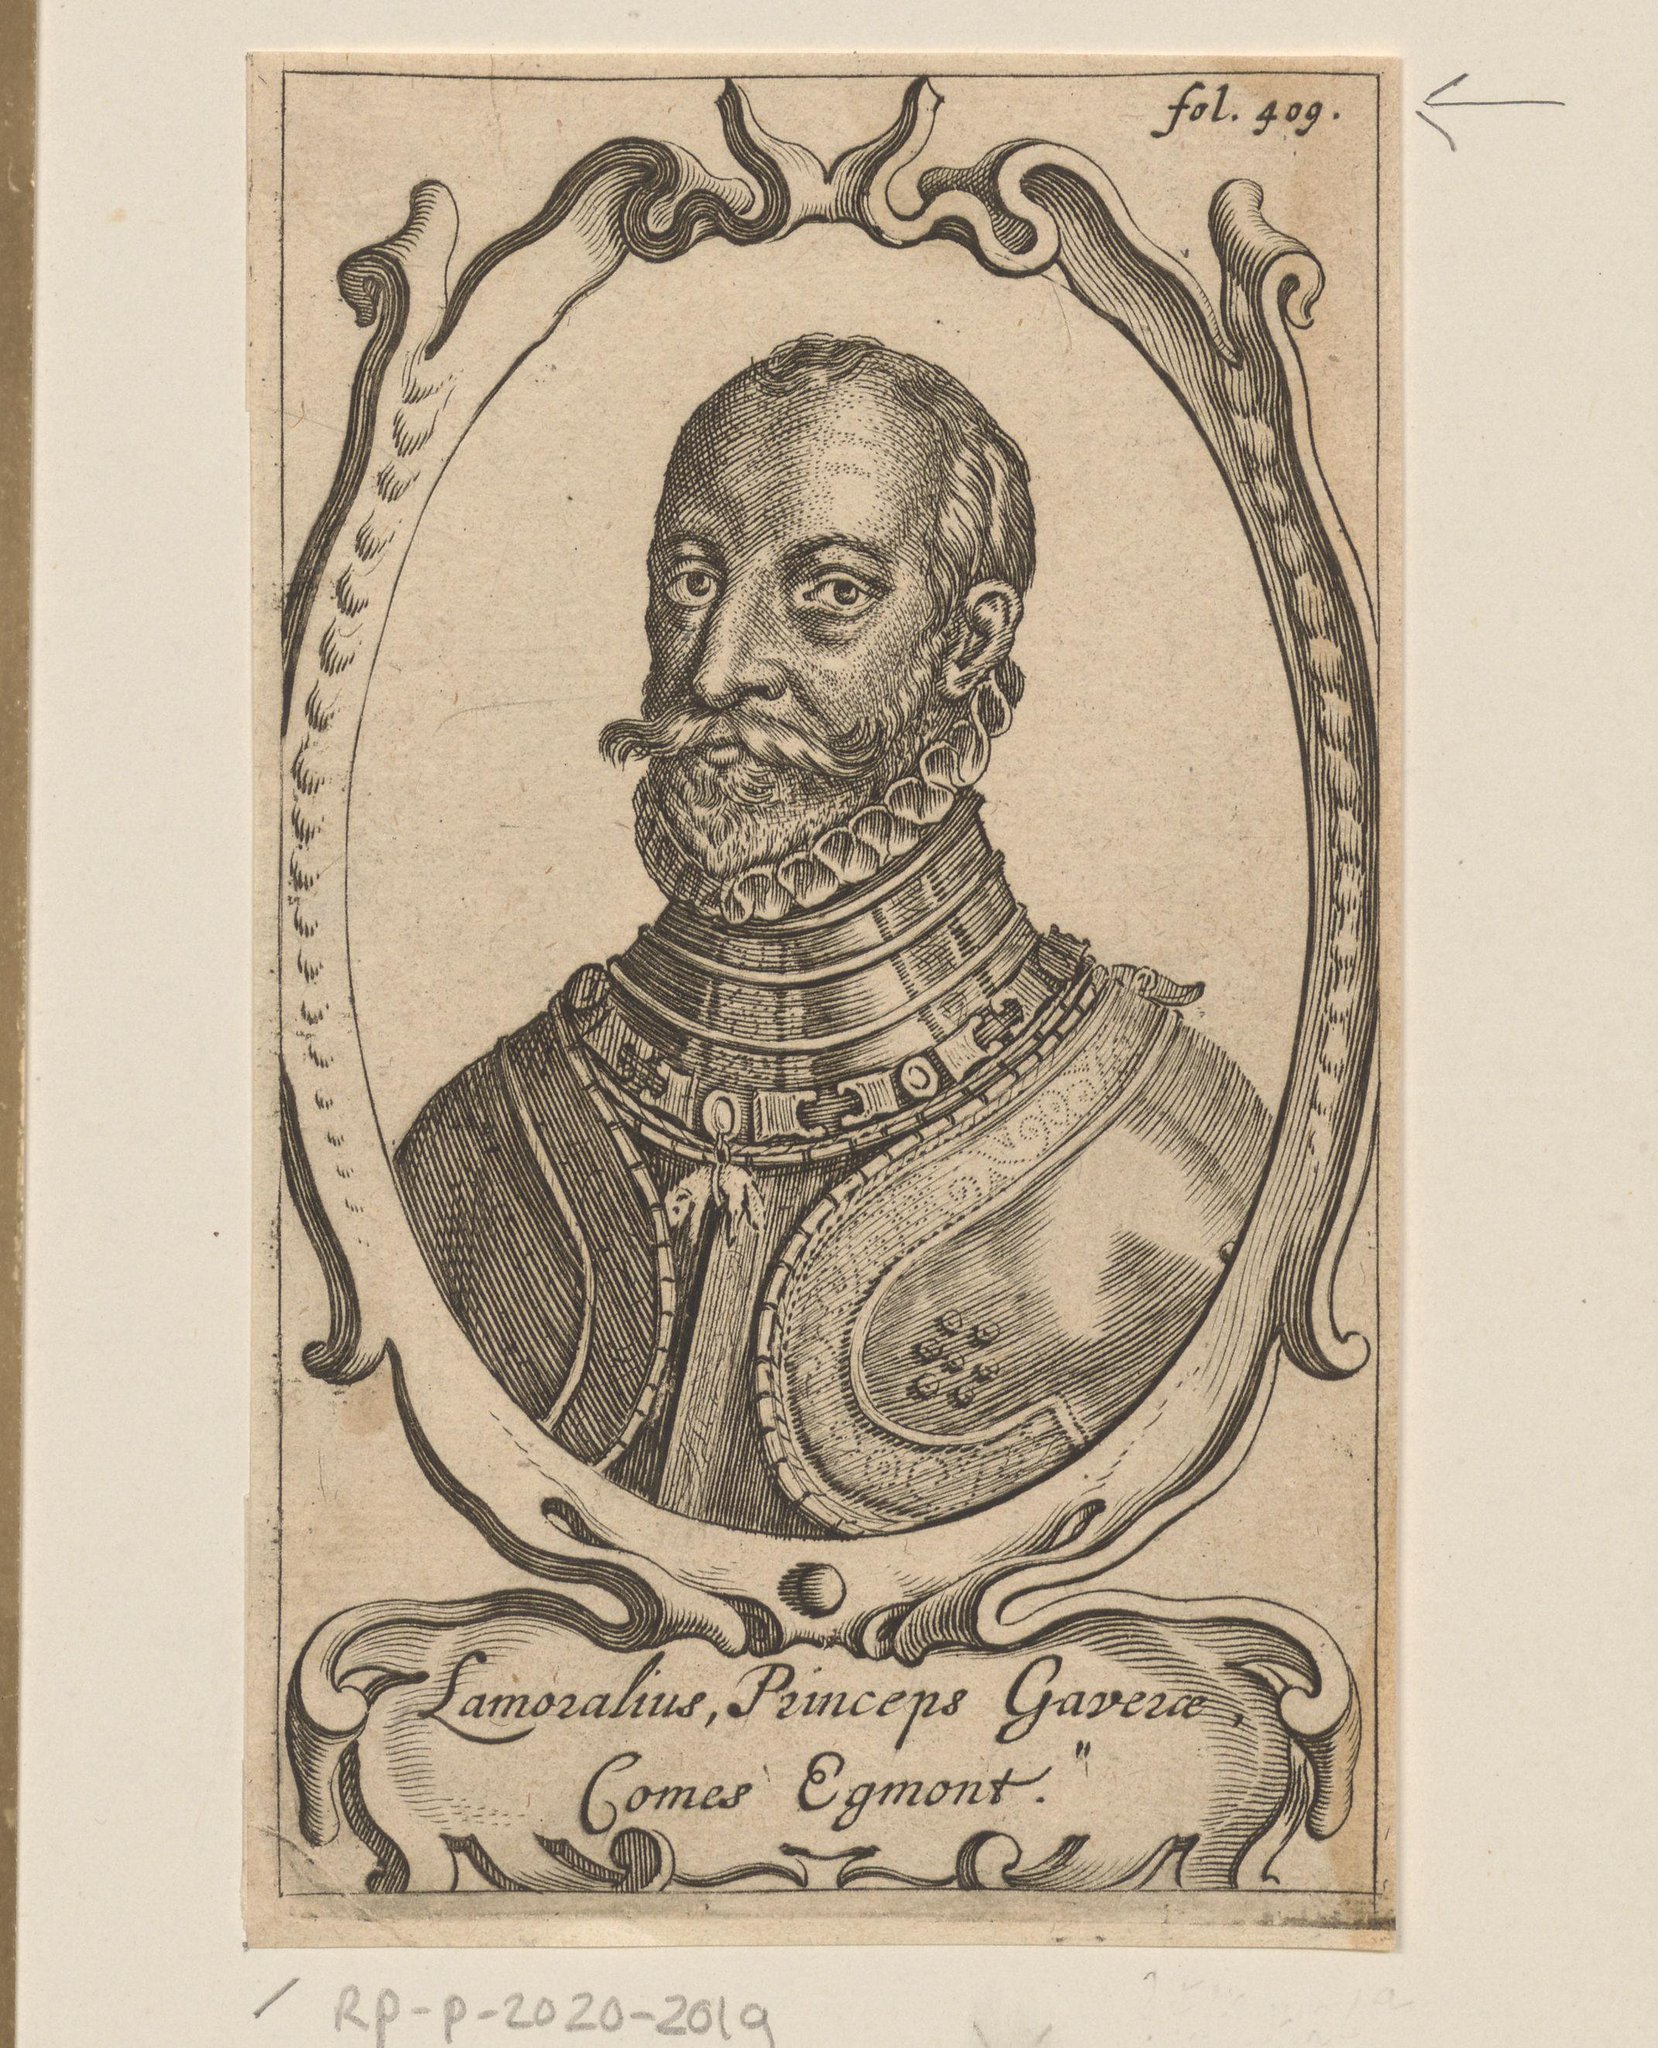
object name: book illustration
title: Portret van Lamoraal van Egmond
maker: Anonymous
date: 1656-1666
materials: paper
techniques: engraving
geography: northern netherlands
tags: brussels, earl, historical persons, knighthood order of the golden fleece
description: Prent mogelijk uit: Brachelius, Johannes Adolphus. Historia nostri temporis, dat is geschiedenis onses tijts (…). Rotterdam: Andries van Hoogenhuysen, 1656. Prent mogelijk ook gebruikt in de 1659- en 1666-editie.